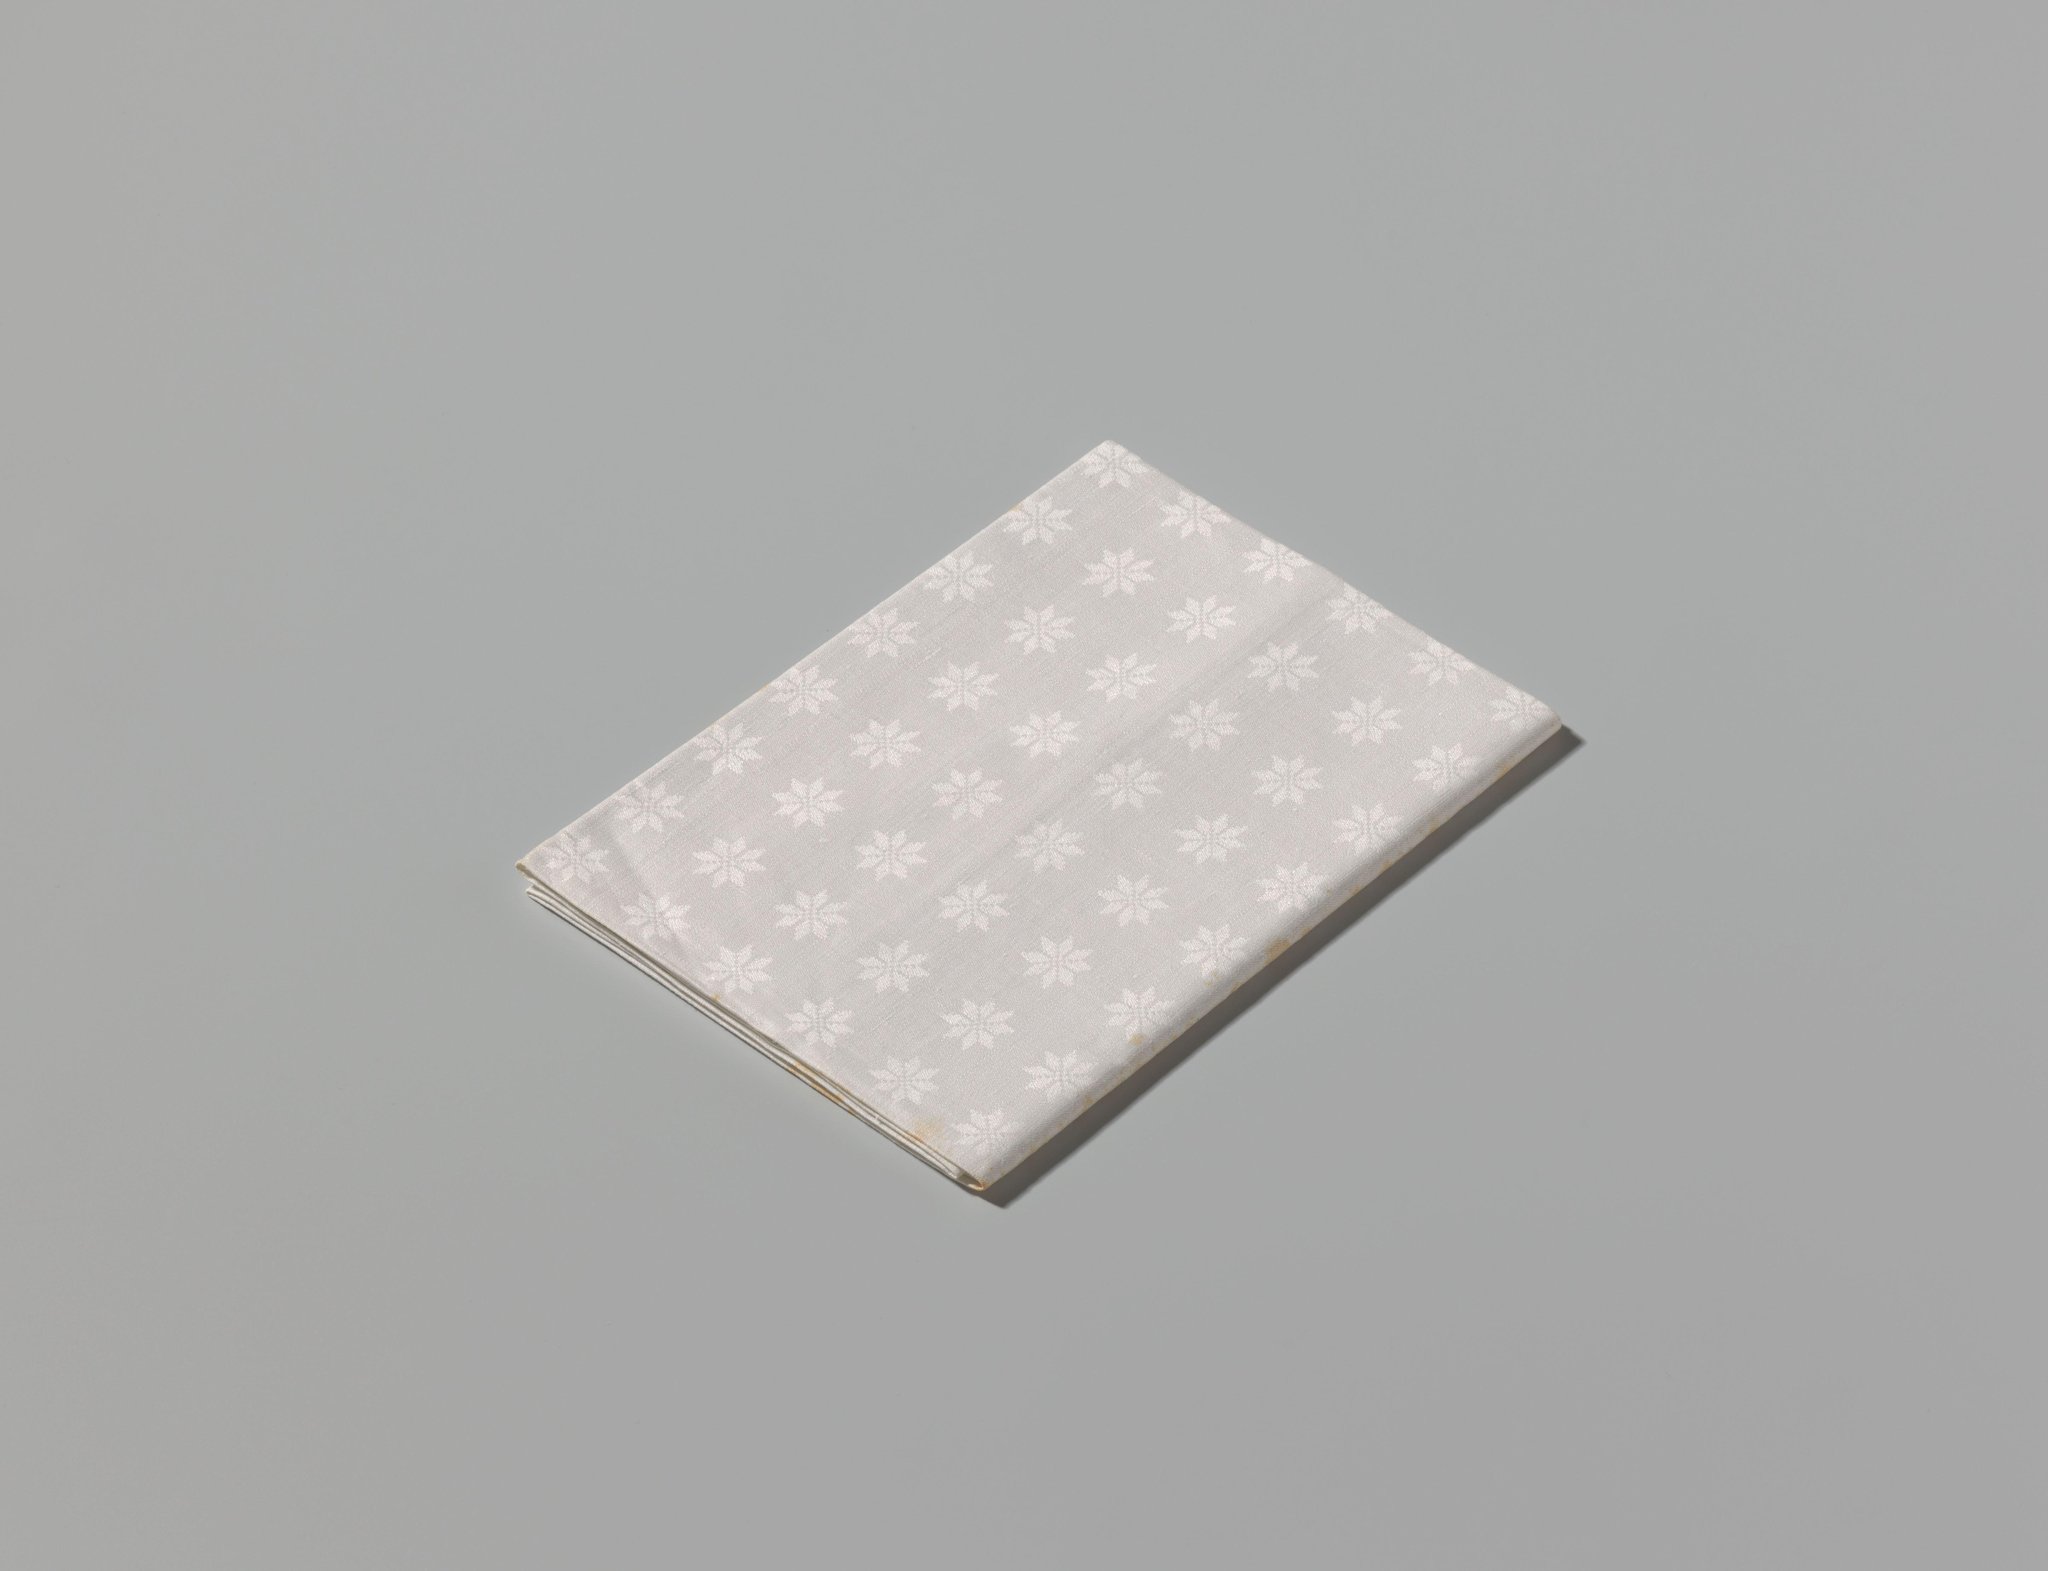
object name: towel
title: Handdoek van wit linnen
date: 1825-1875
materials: linen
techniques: damask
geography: netherlands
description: Wit linnendamasten handdoek met een patroon van rijen sterretjes en randen rondom, merk HW 24.